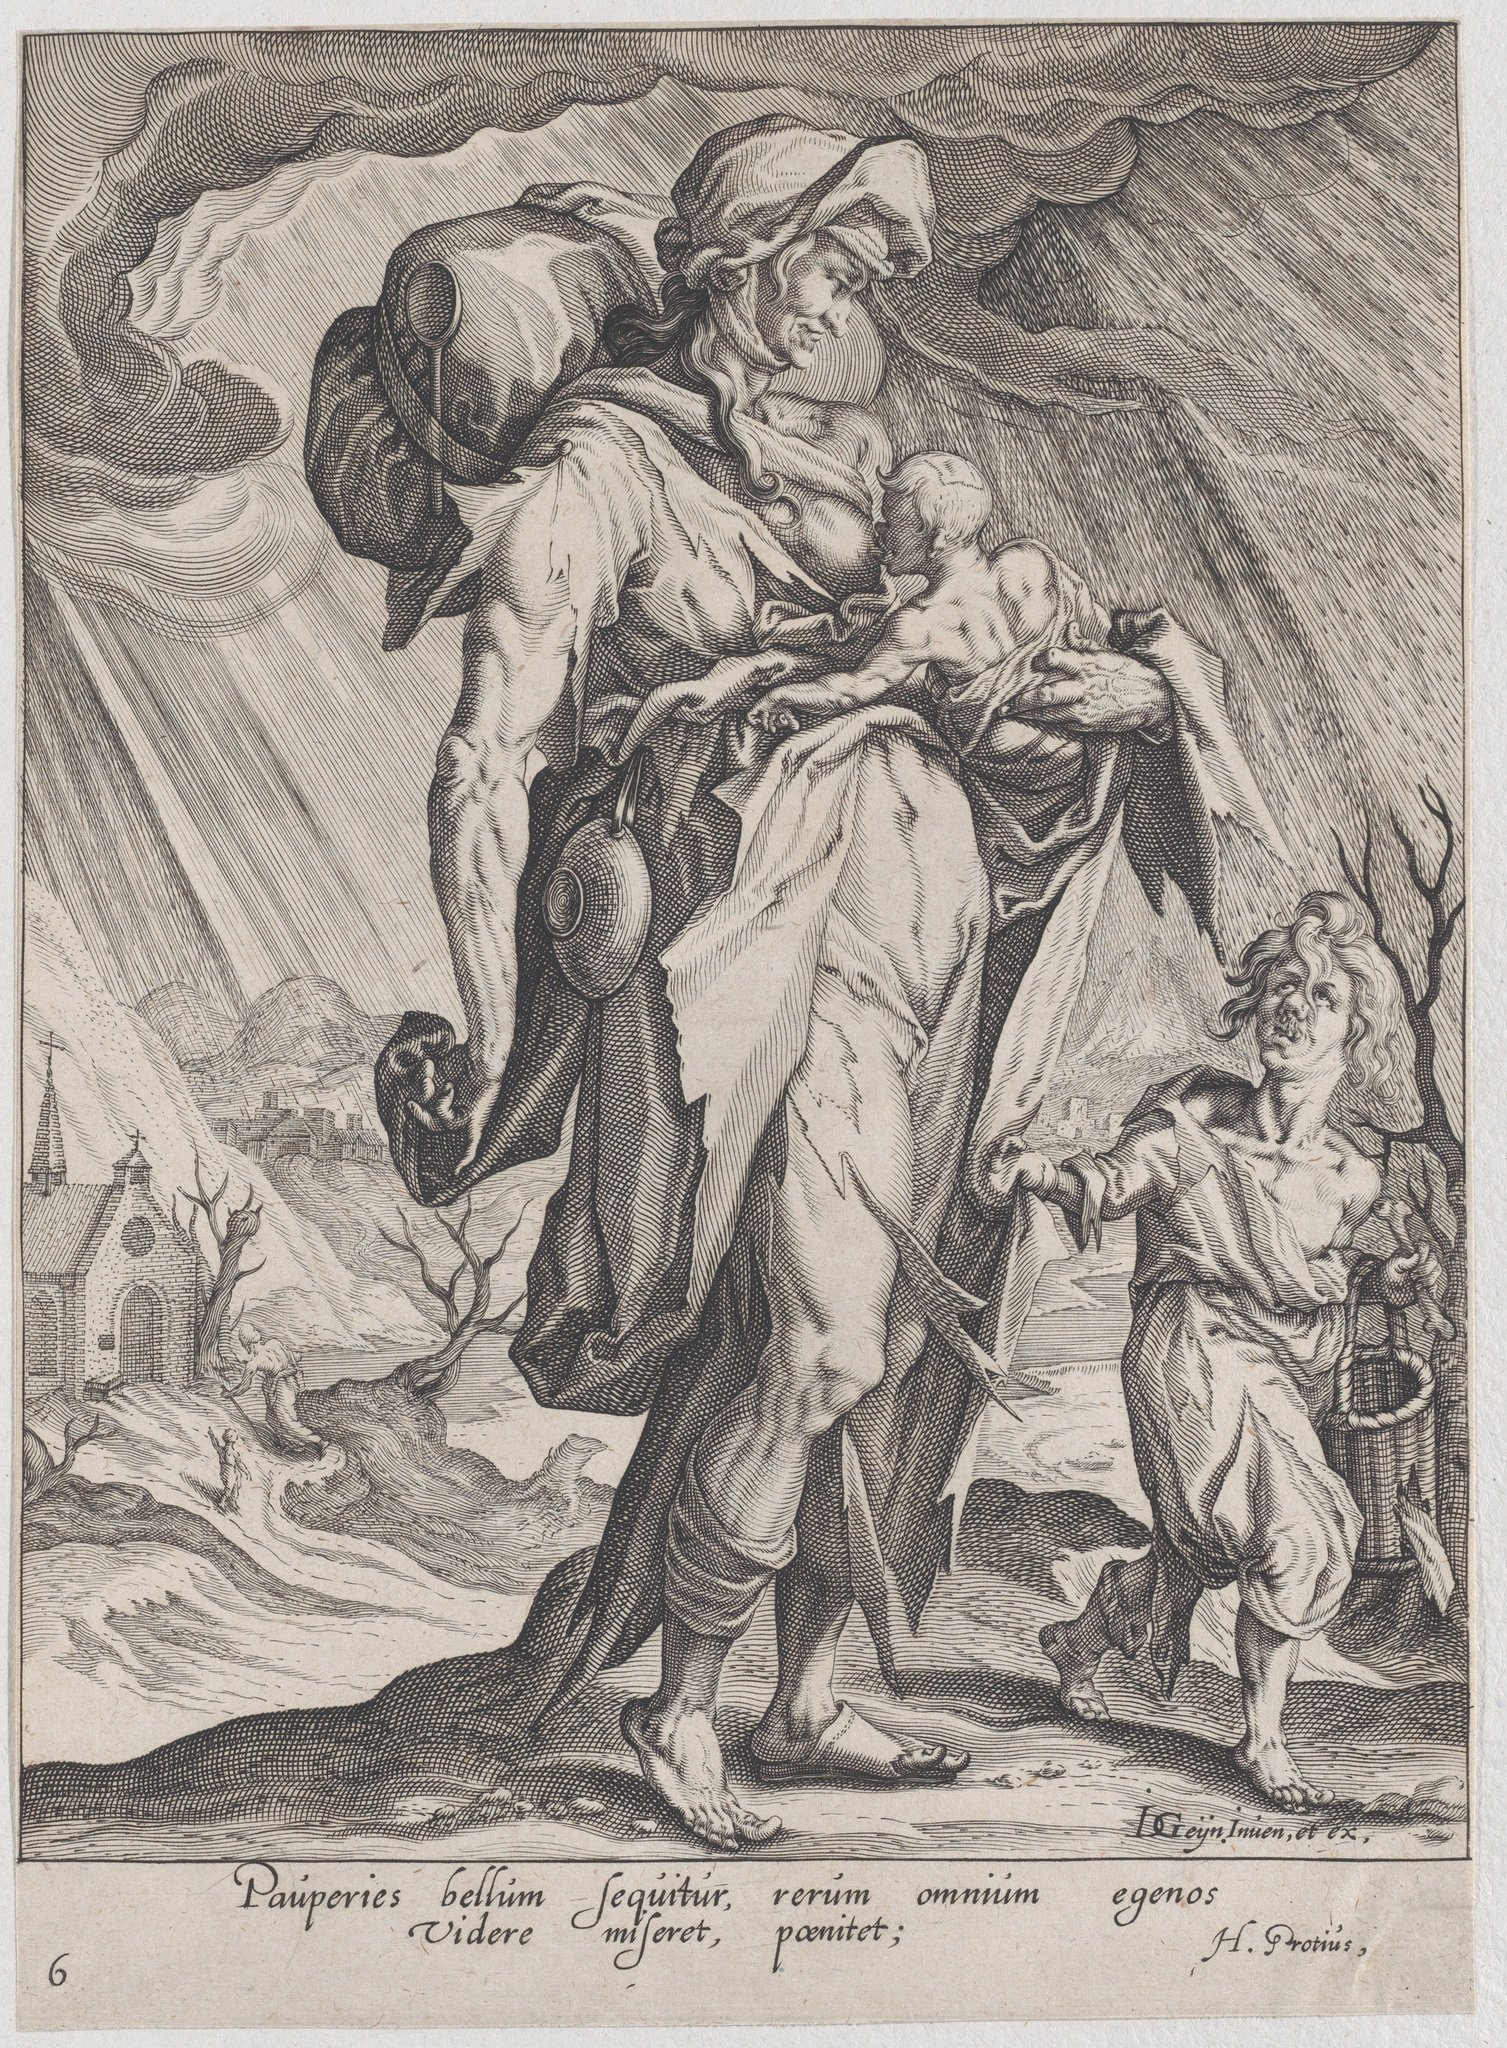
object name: print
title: Poverty, from "Virtues and Vices"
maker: zacharias dolendo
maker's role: artist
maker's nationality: netherlandish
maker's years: 1561-1604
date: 1596-1597